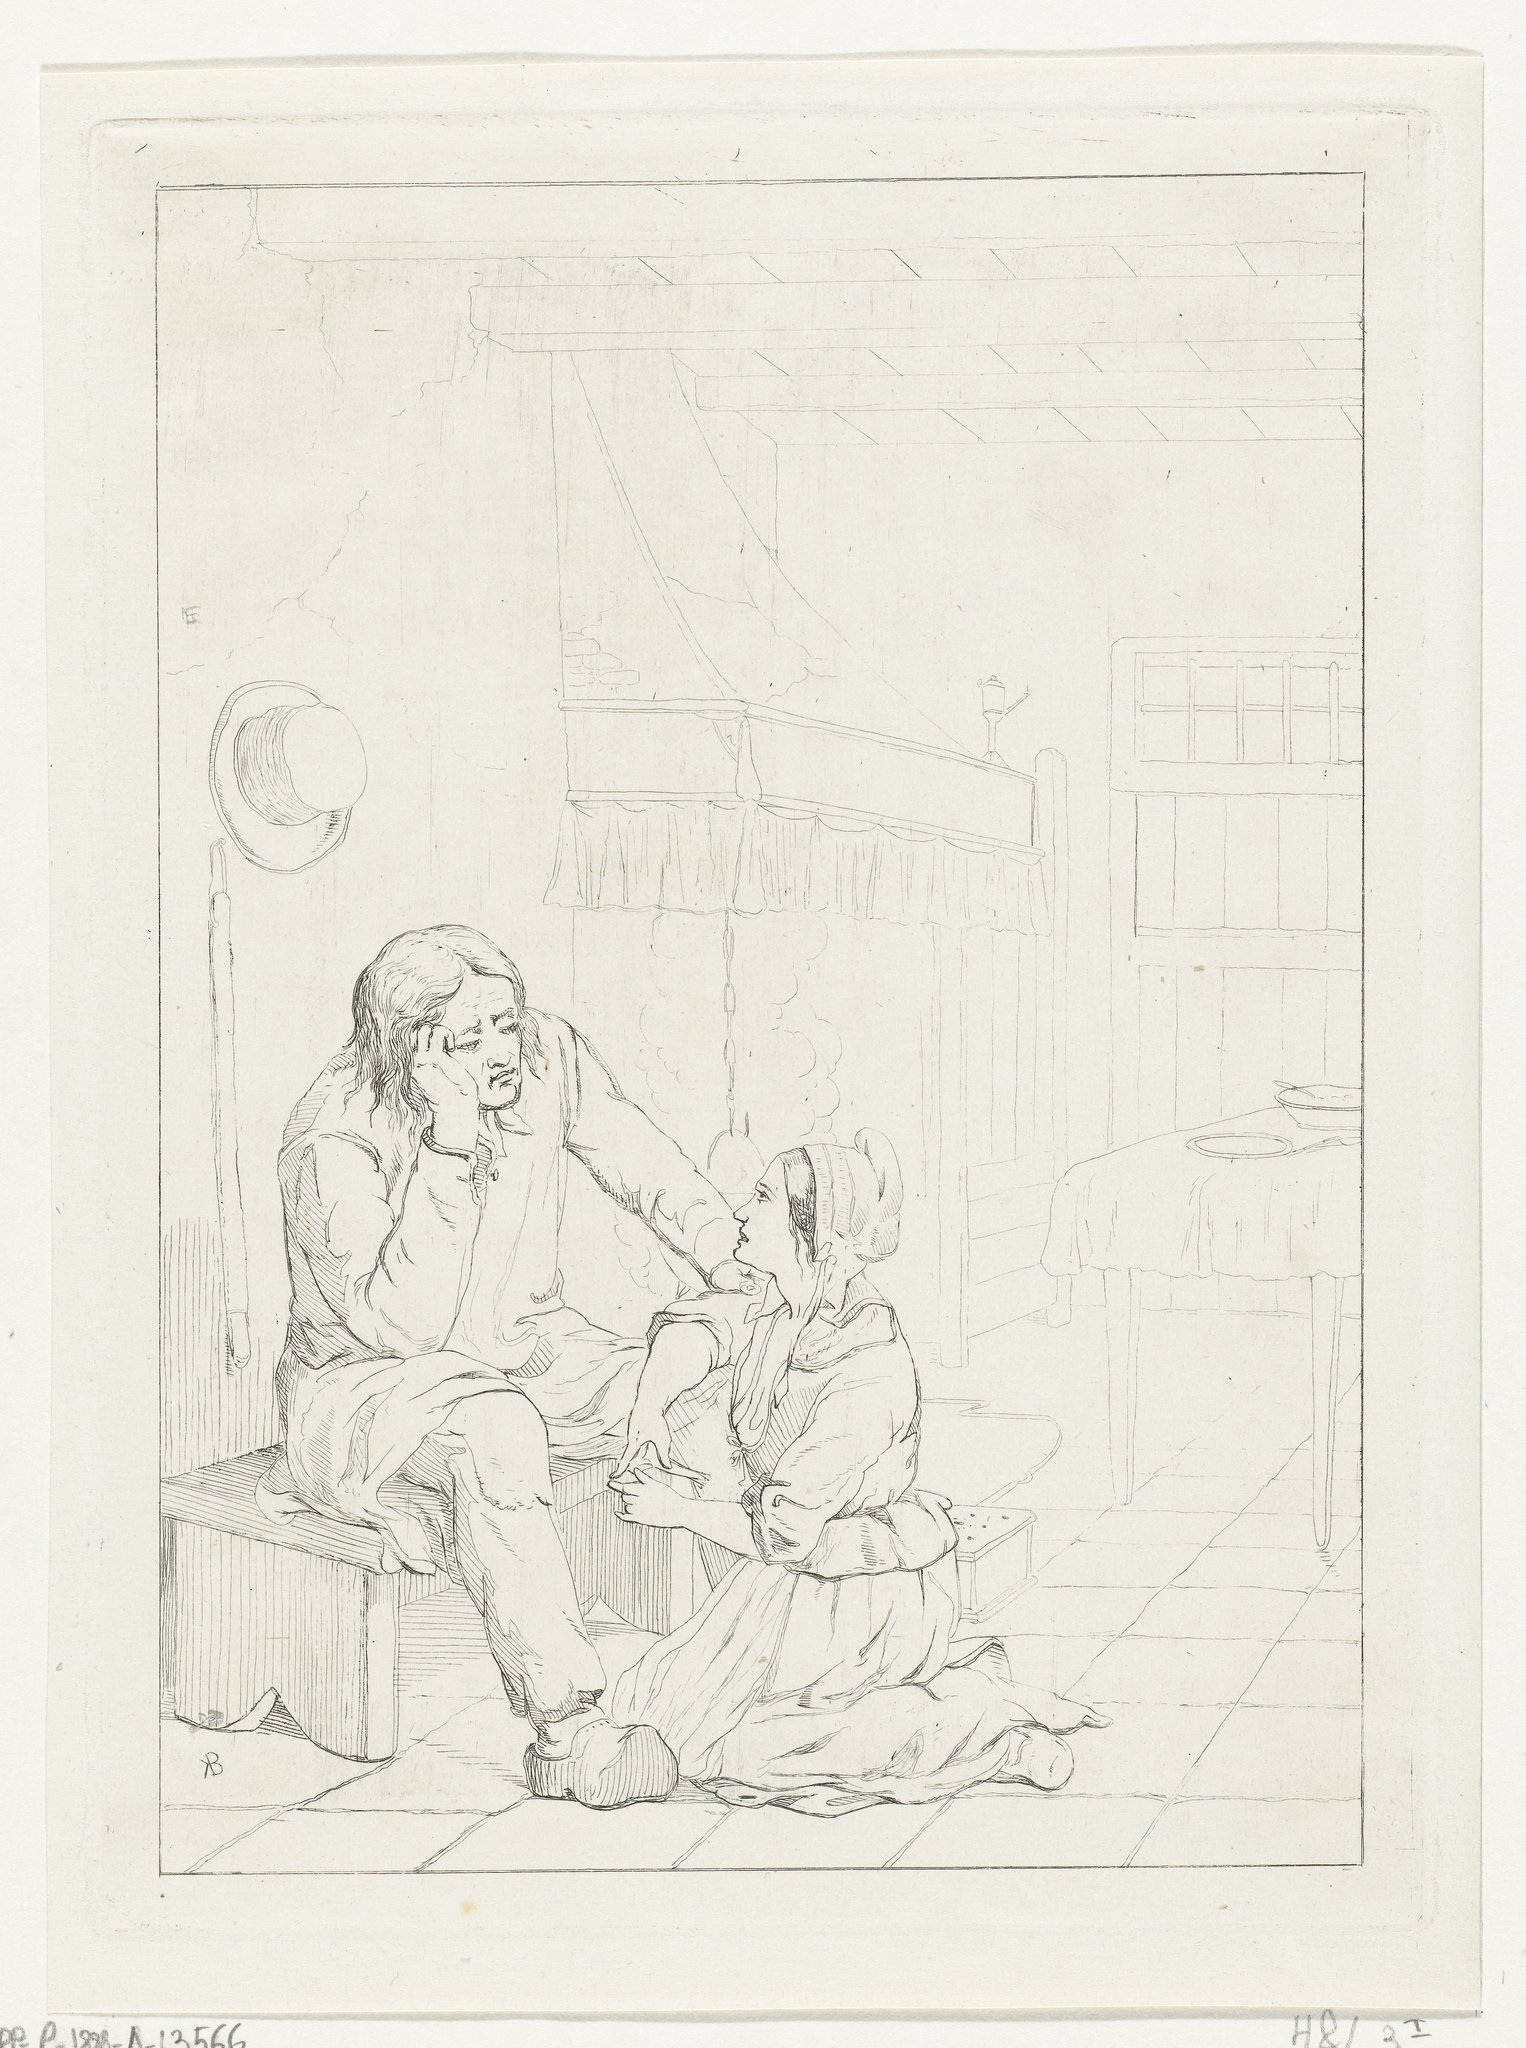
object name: print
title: Verliefd paar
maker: karel frederik bombled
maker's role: draughtsman, print maker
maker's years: 1822-1902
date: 1832-1888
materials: paper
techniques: etching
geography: netherlands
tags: kitchen-interior, (lovers) caressing each other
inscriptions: collector's mark: Lugt 2228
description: Een rustieke keuken met een haard en een keukentafel. Op de voorgrond zit een man op een bankje. Voor hem op de grond zit een jonge vrouw op haar knieën. Ze kijken elkaar in de ogen en de vrouw lijkt een verhaal te vertellen. De man raakt haar teder aan met zijn linkerhand.